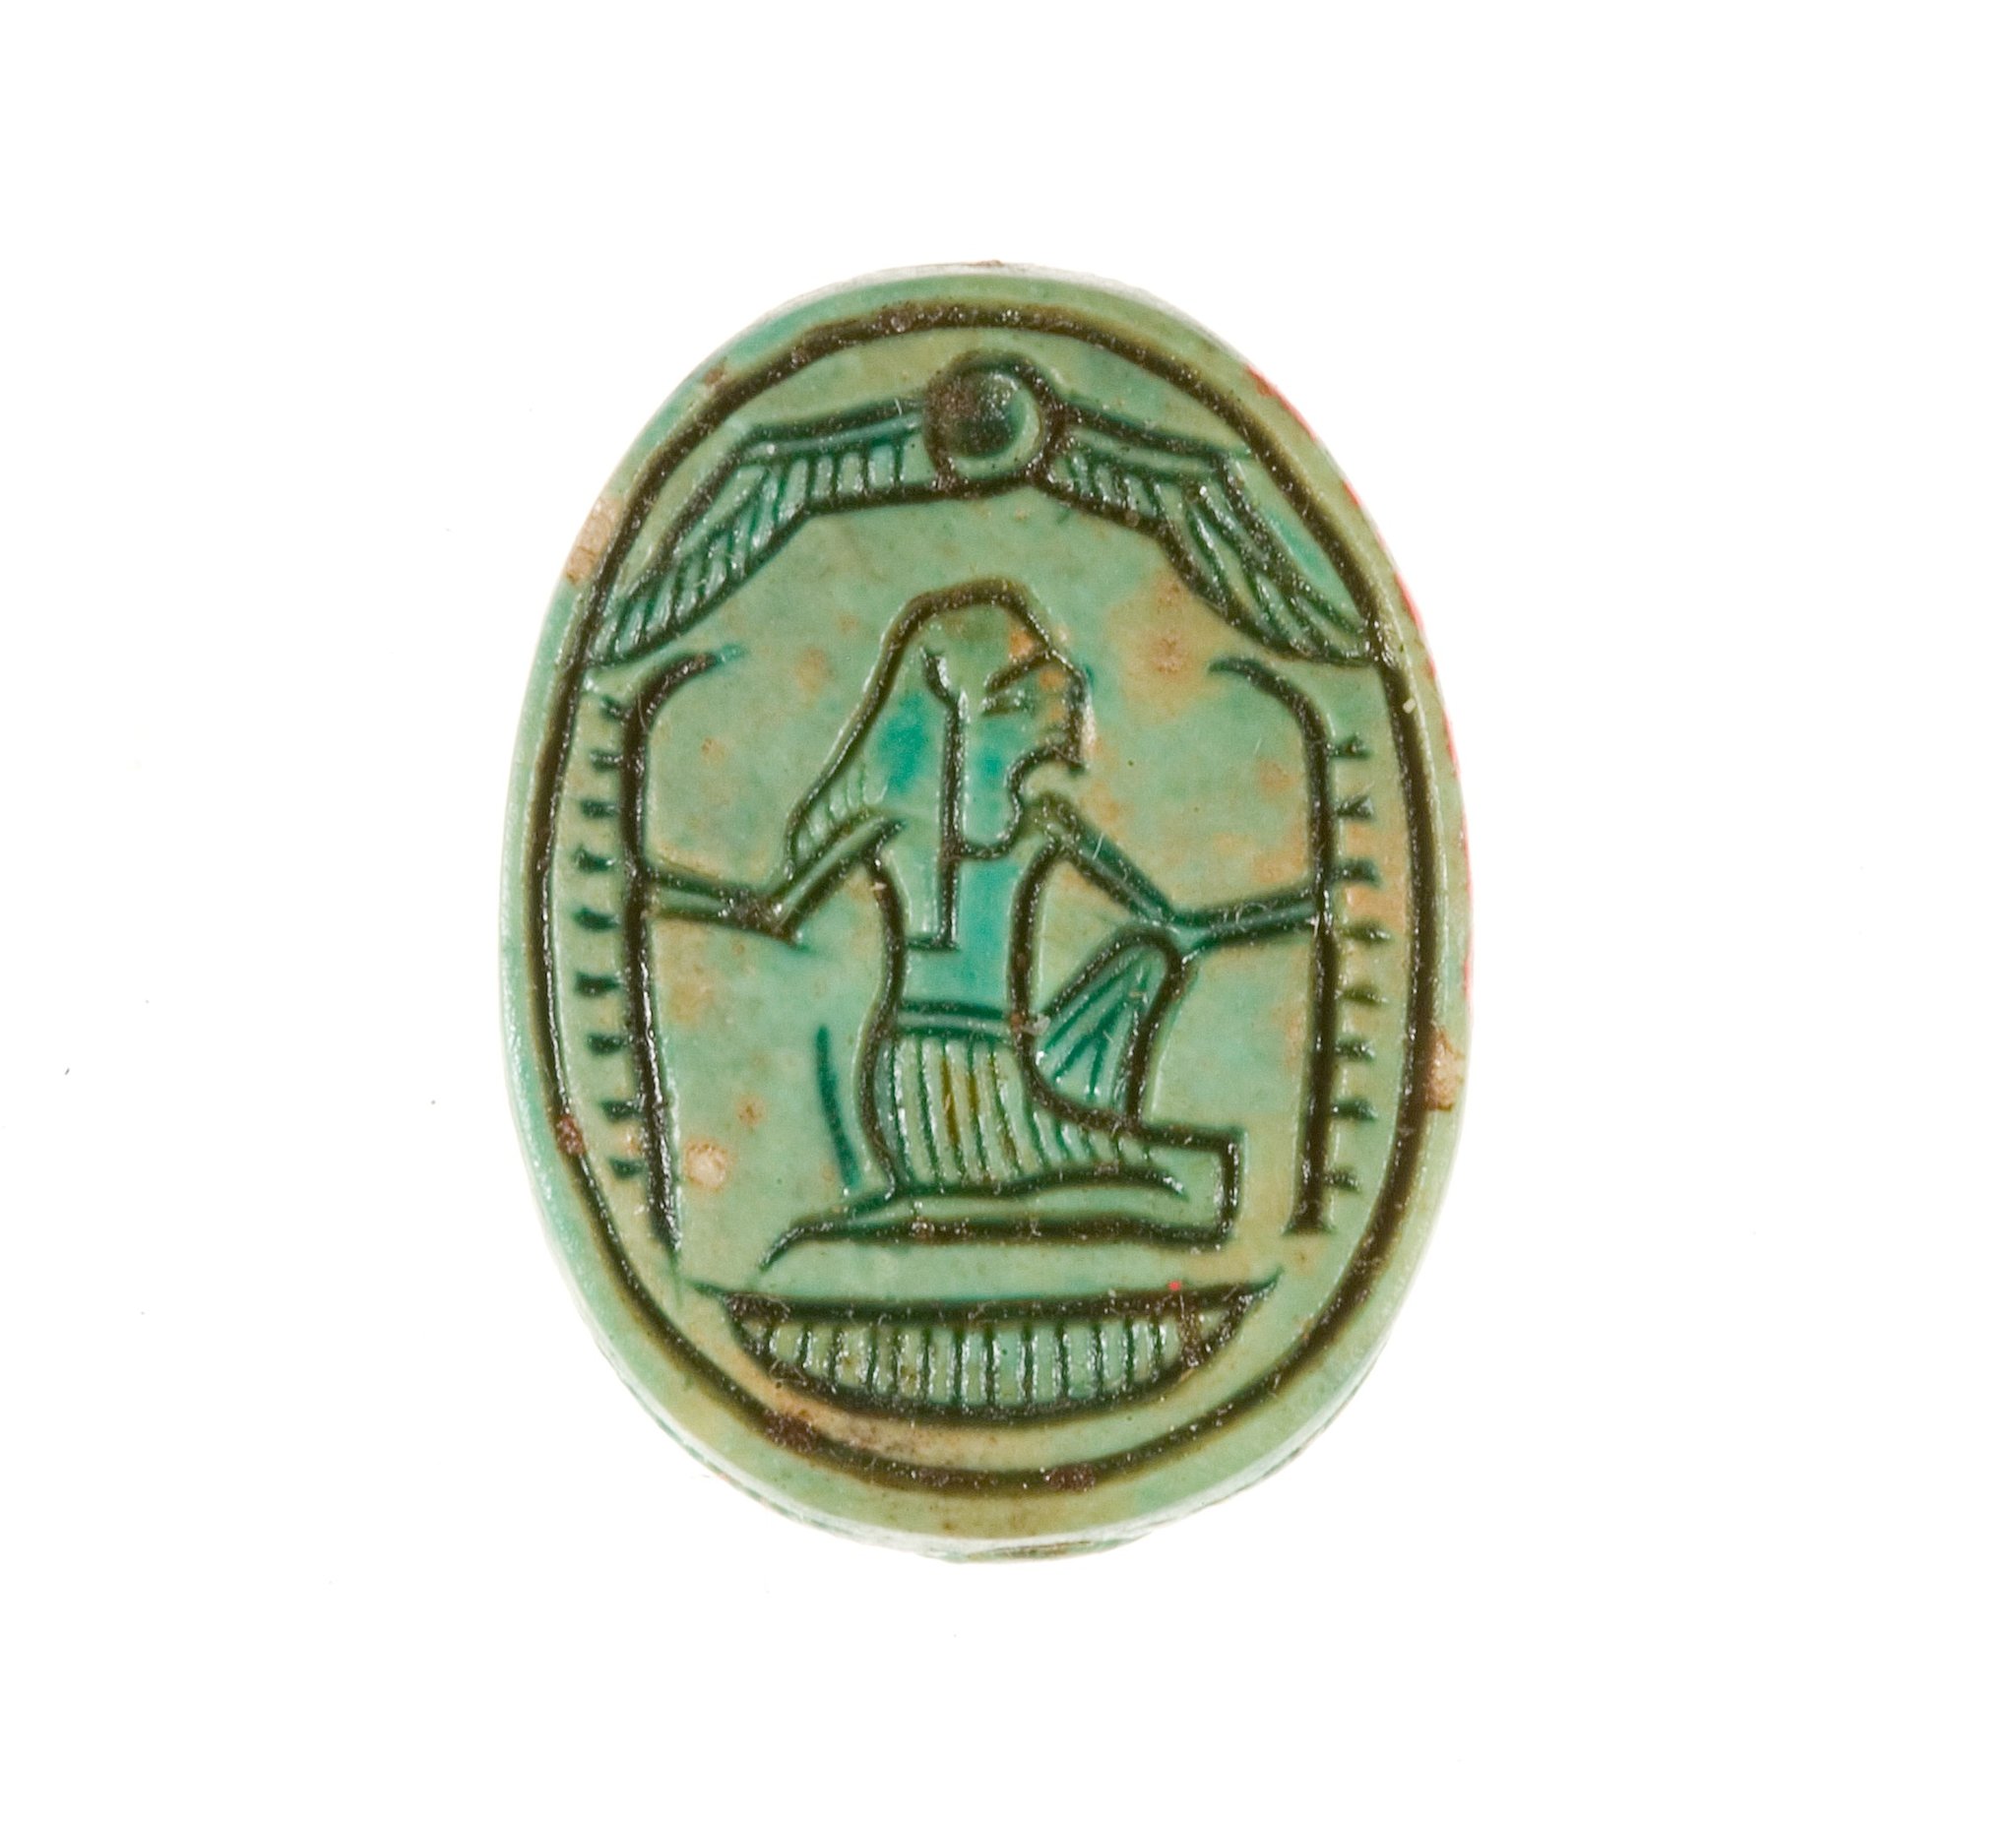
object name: scarab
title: Scarab Inscribed with a Hieroglyphic Motif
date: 1479-1458 BCE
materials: stone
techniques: glazing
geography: egypt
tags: hieroglyphs,scarabs